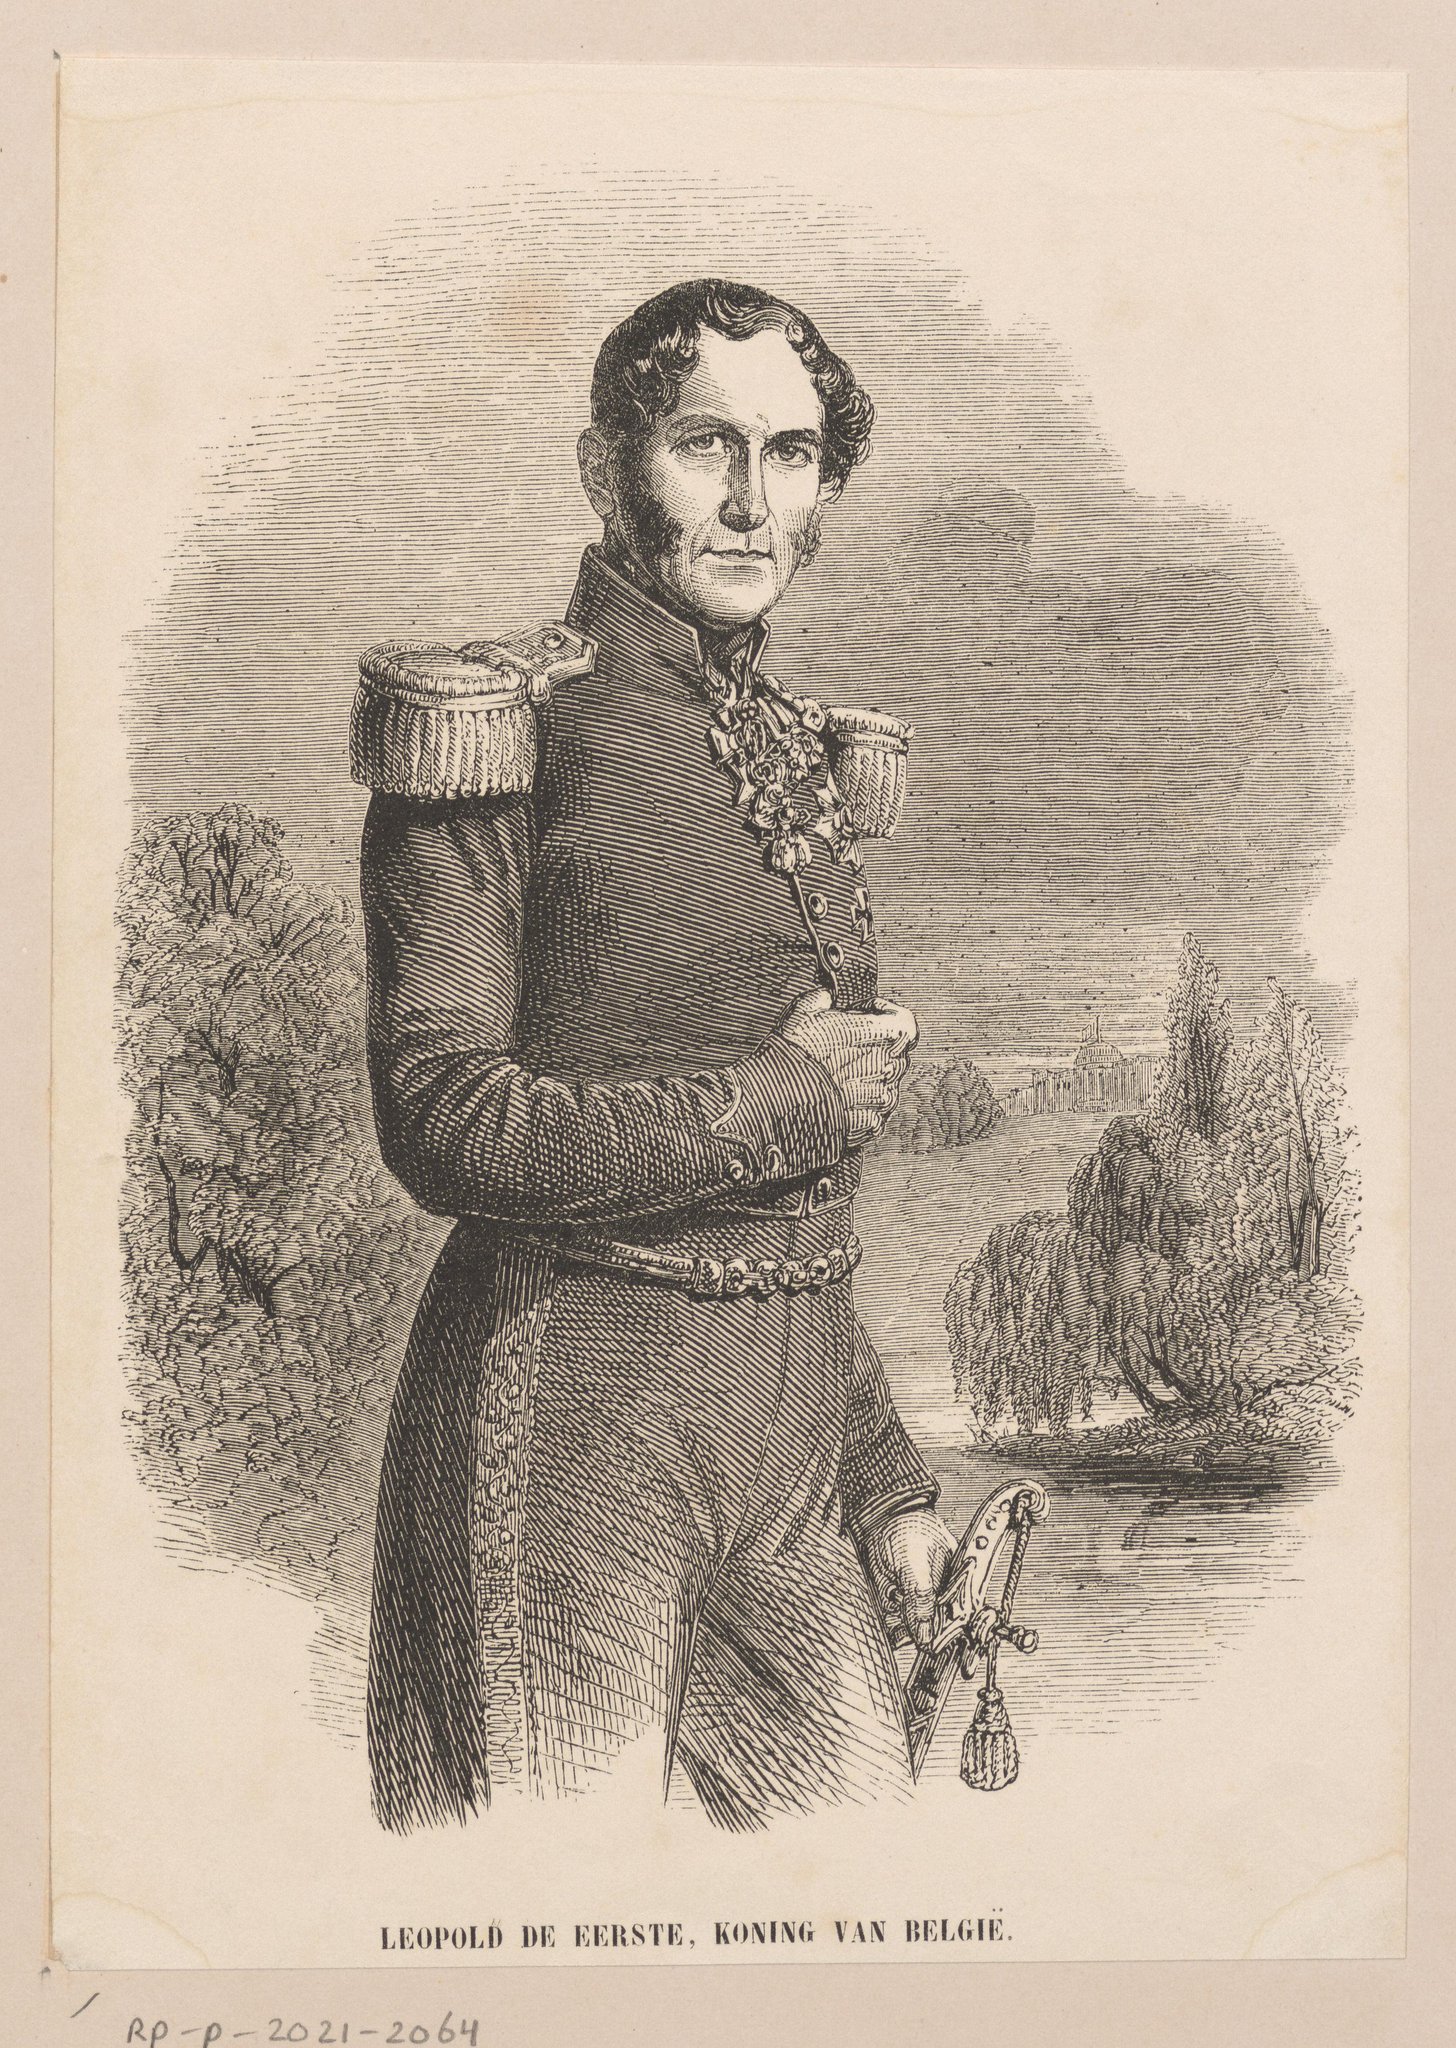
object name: print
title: Portret van Leopold I van België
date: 1850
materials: paper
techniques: letterpress printing, engraving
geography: netherlands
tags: laeken, leopold i (koning der belgen), knighthood order, historical persons, hacking and thrusting weapons: sword, (military) uniforms, king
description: Prent waarschijnlijk uit: De Tijdspiegel 1 (1850).